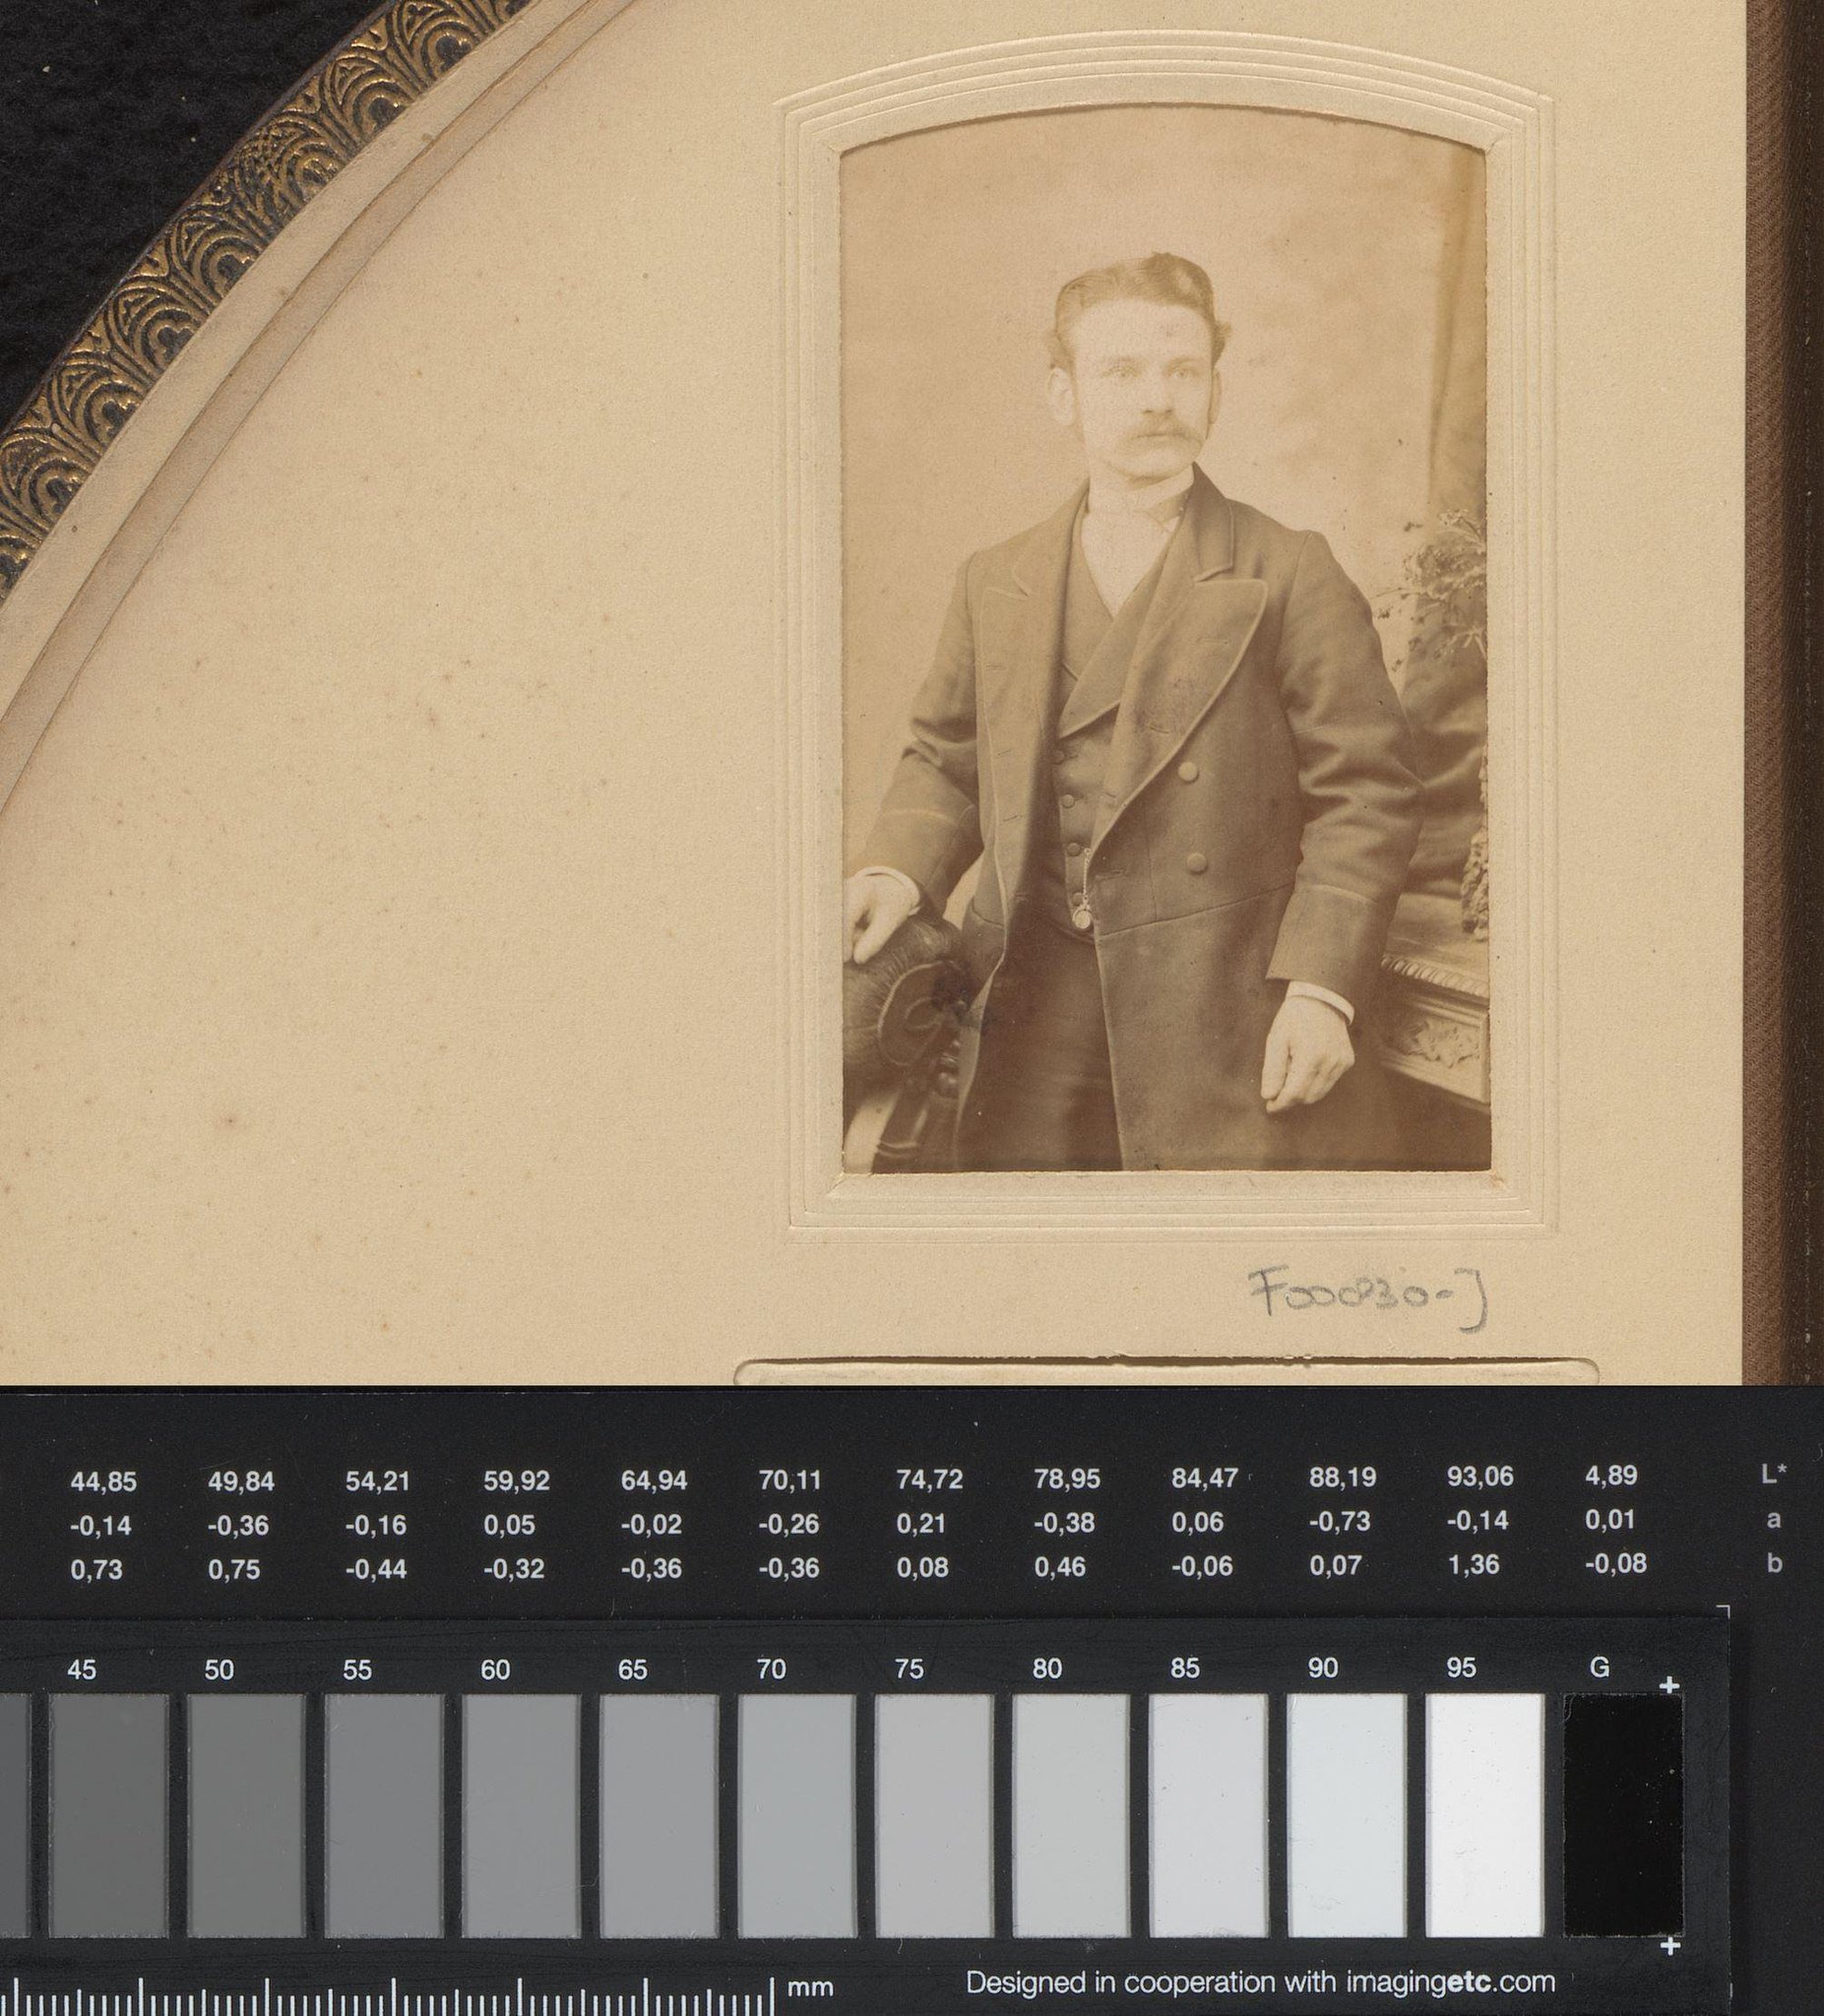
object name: carte de visite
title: Portret van David Williams als staande man met overjas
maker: william george henry wright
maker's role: fotograaf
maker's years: 1860-1915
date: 1890-1910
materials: cardboard, photographic support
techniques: albumen print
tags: moustache, adult man, historical persons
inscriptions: annotation: ‘age 33// Willims/ 12442’, inscription: ‘Phototgraphic Studios/ W. Wright/ 188 190/ Bethenal Green R/ (...)/ London’